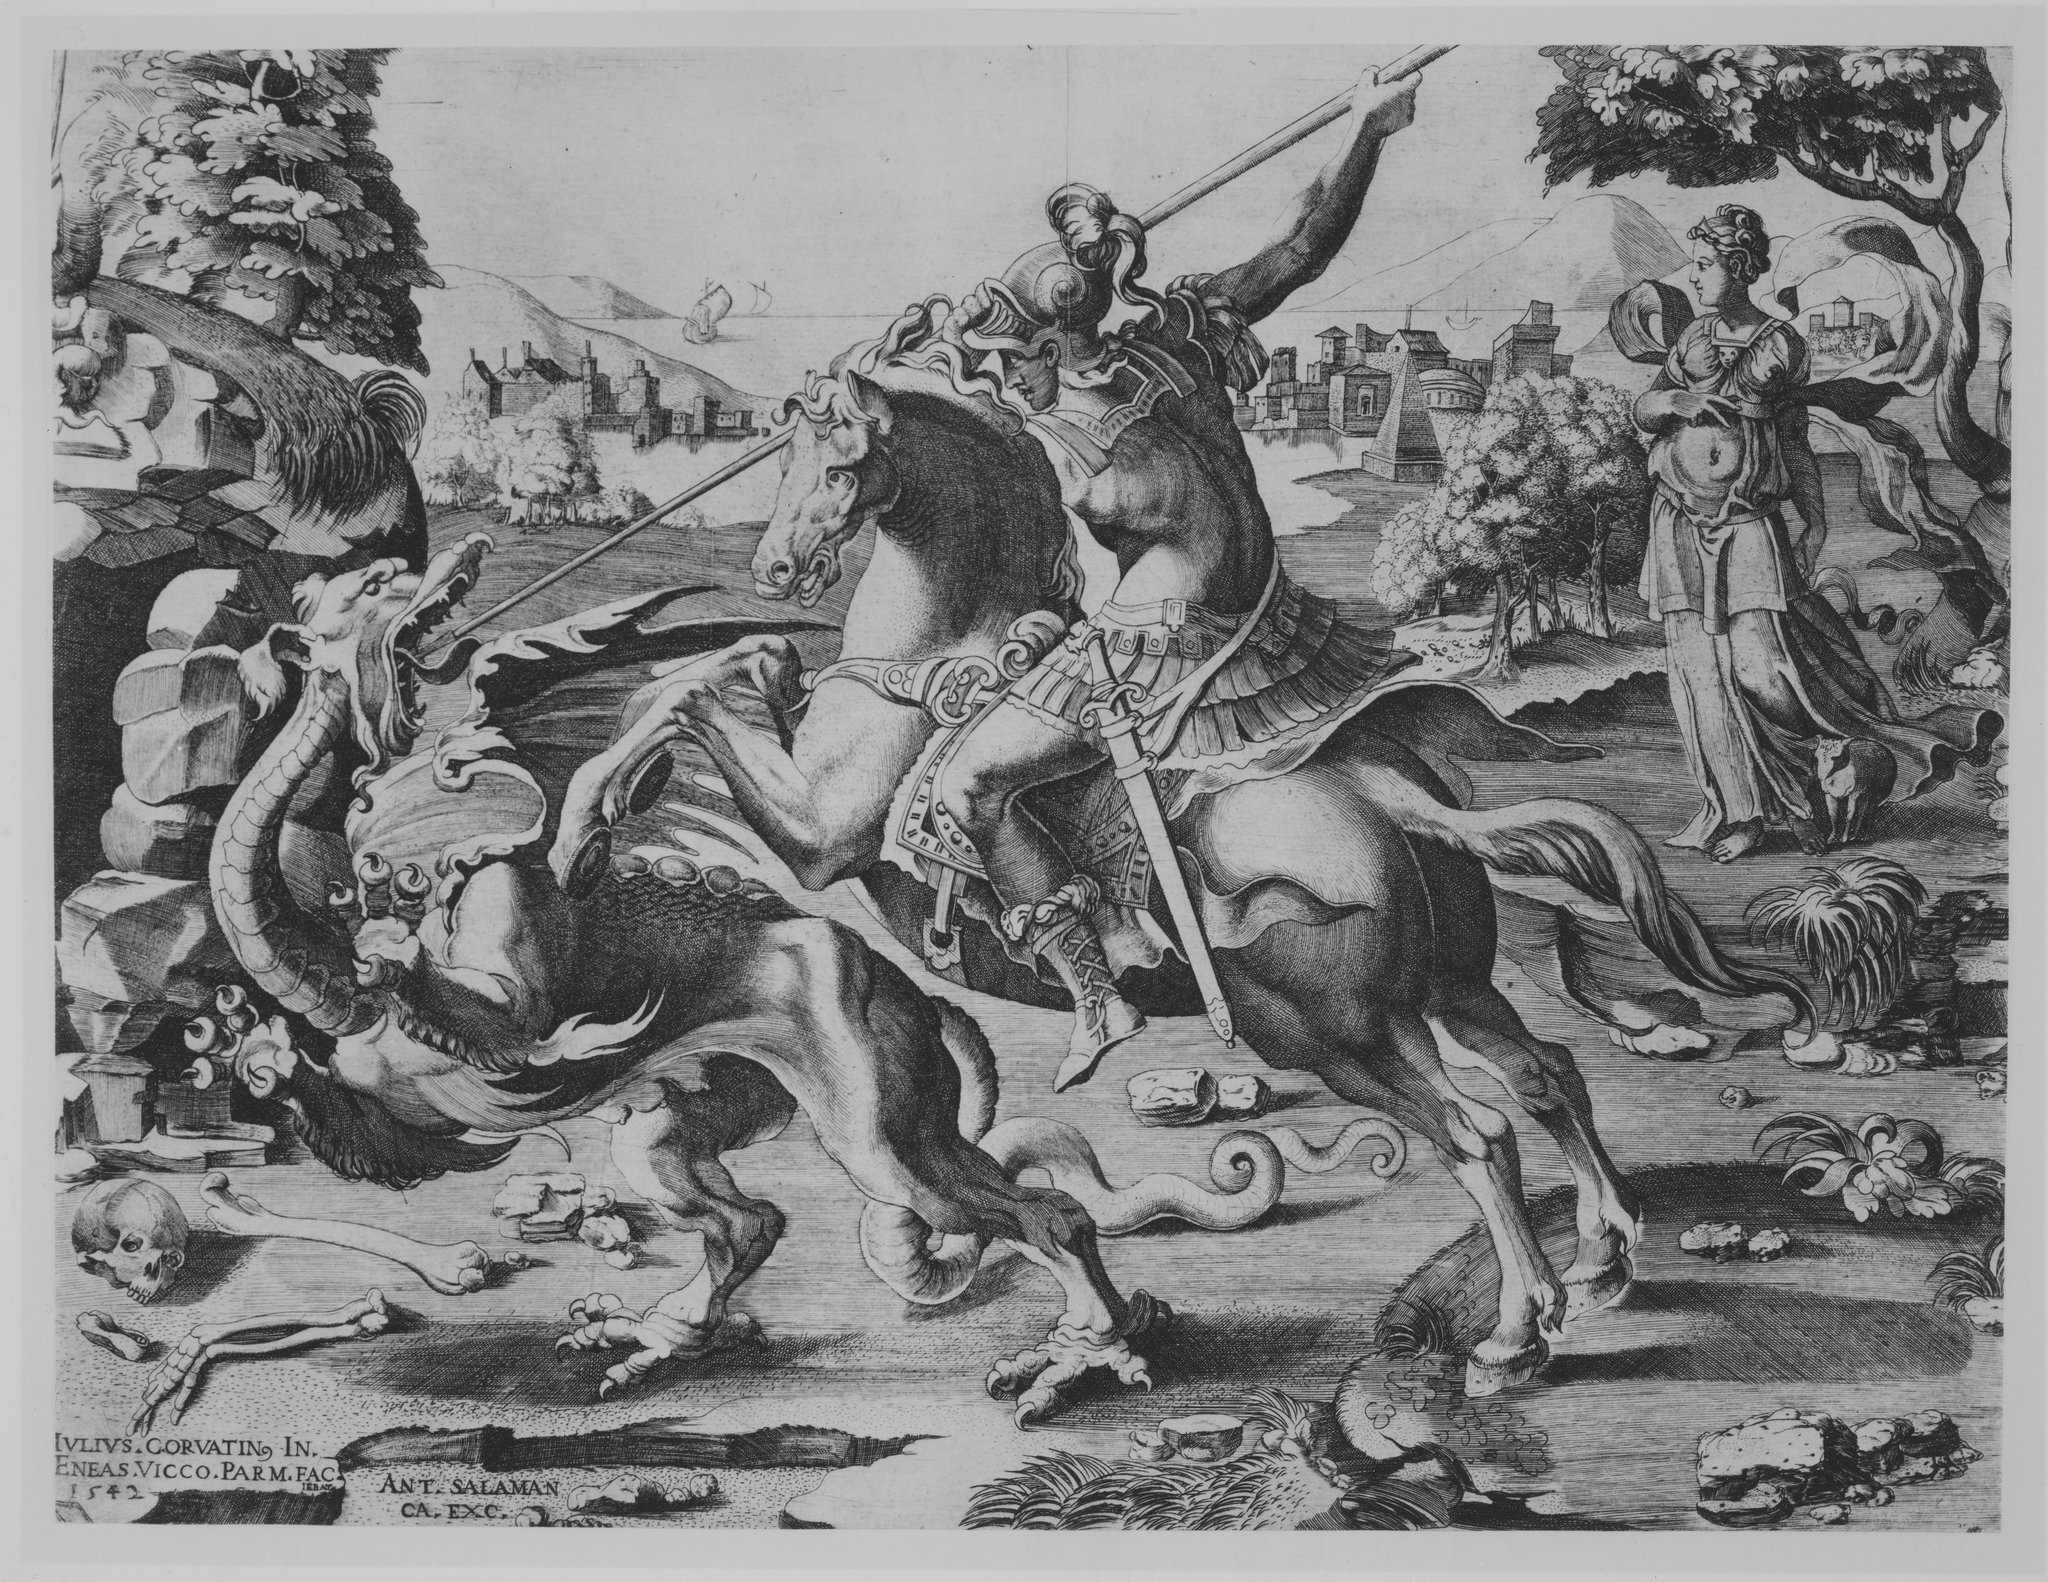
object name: print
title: St George Killing the Dragon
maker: enea vico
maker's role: artist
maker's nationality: italian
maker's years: 1523-1567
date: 1542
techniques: engraving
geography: rome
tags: spears,women,dragons,horses,saint george